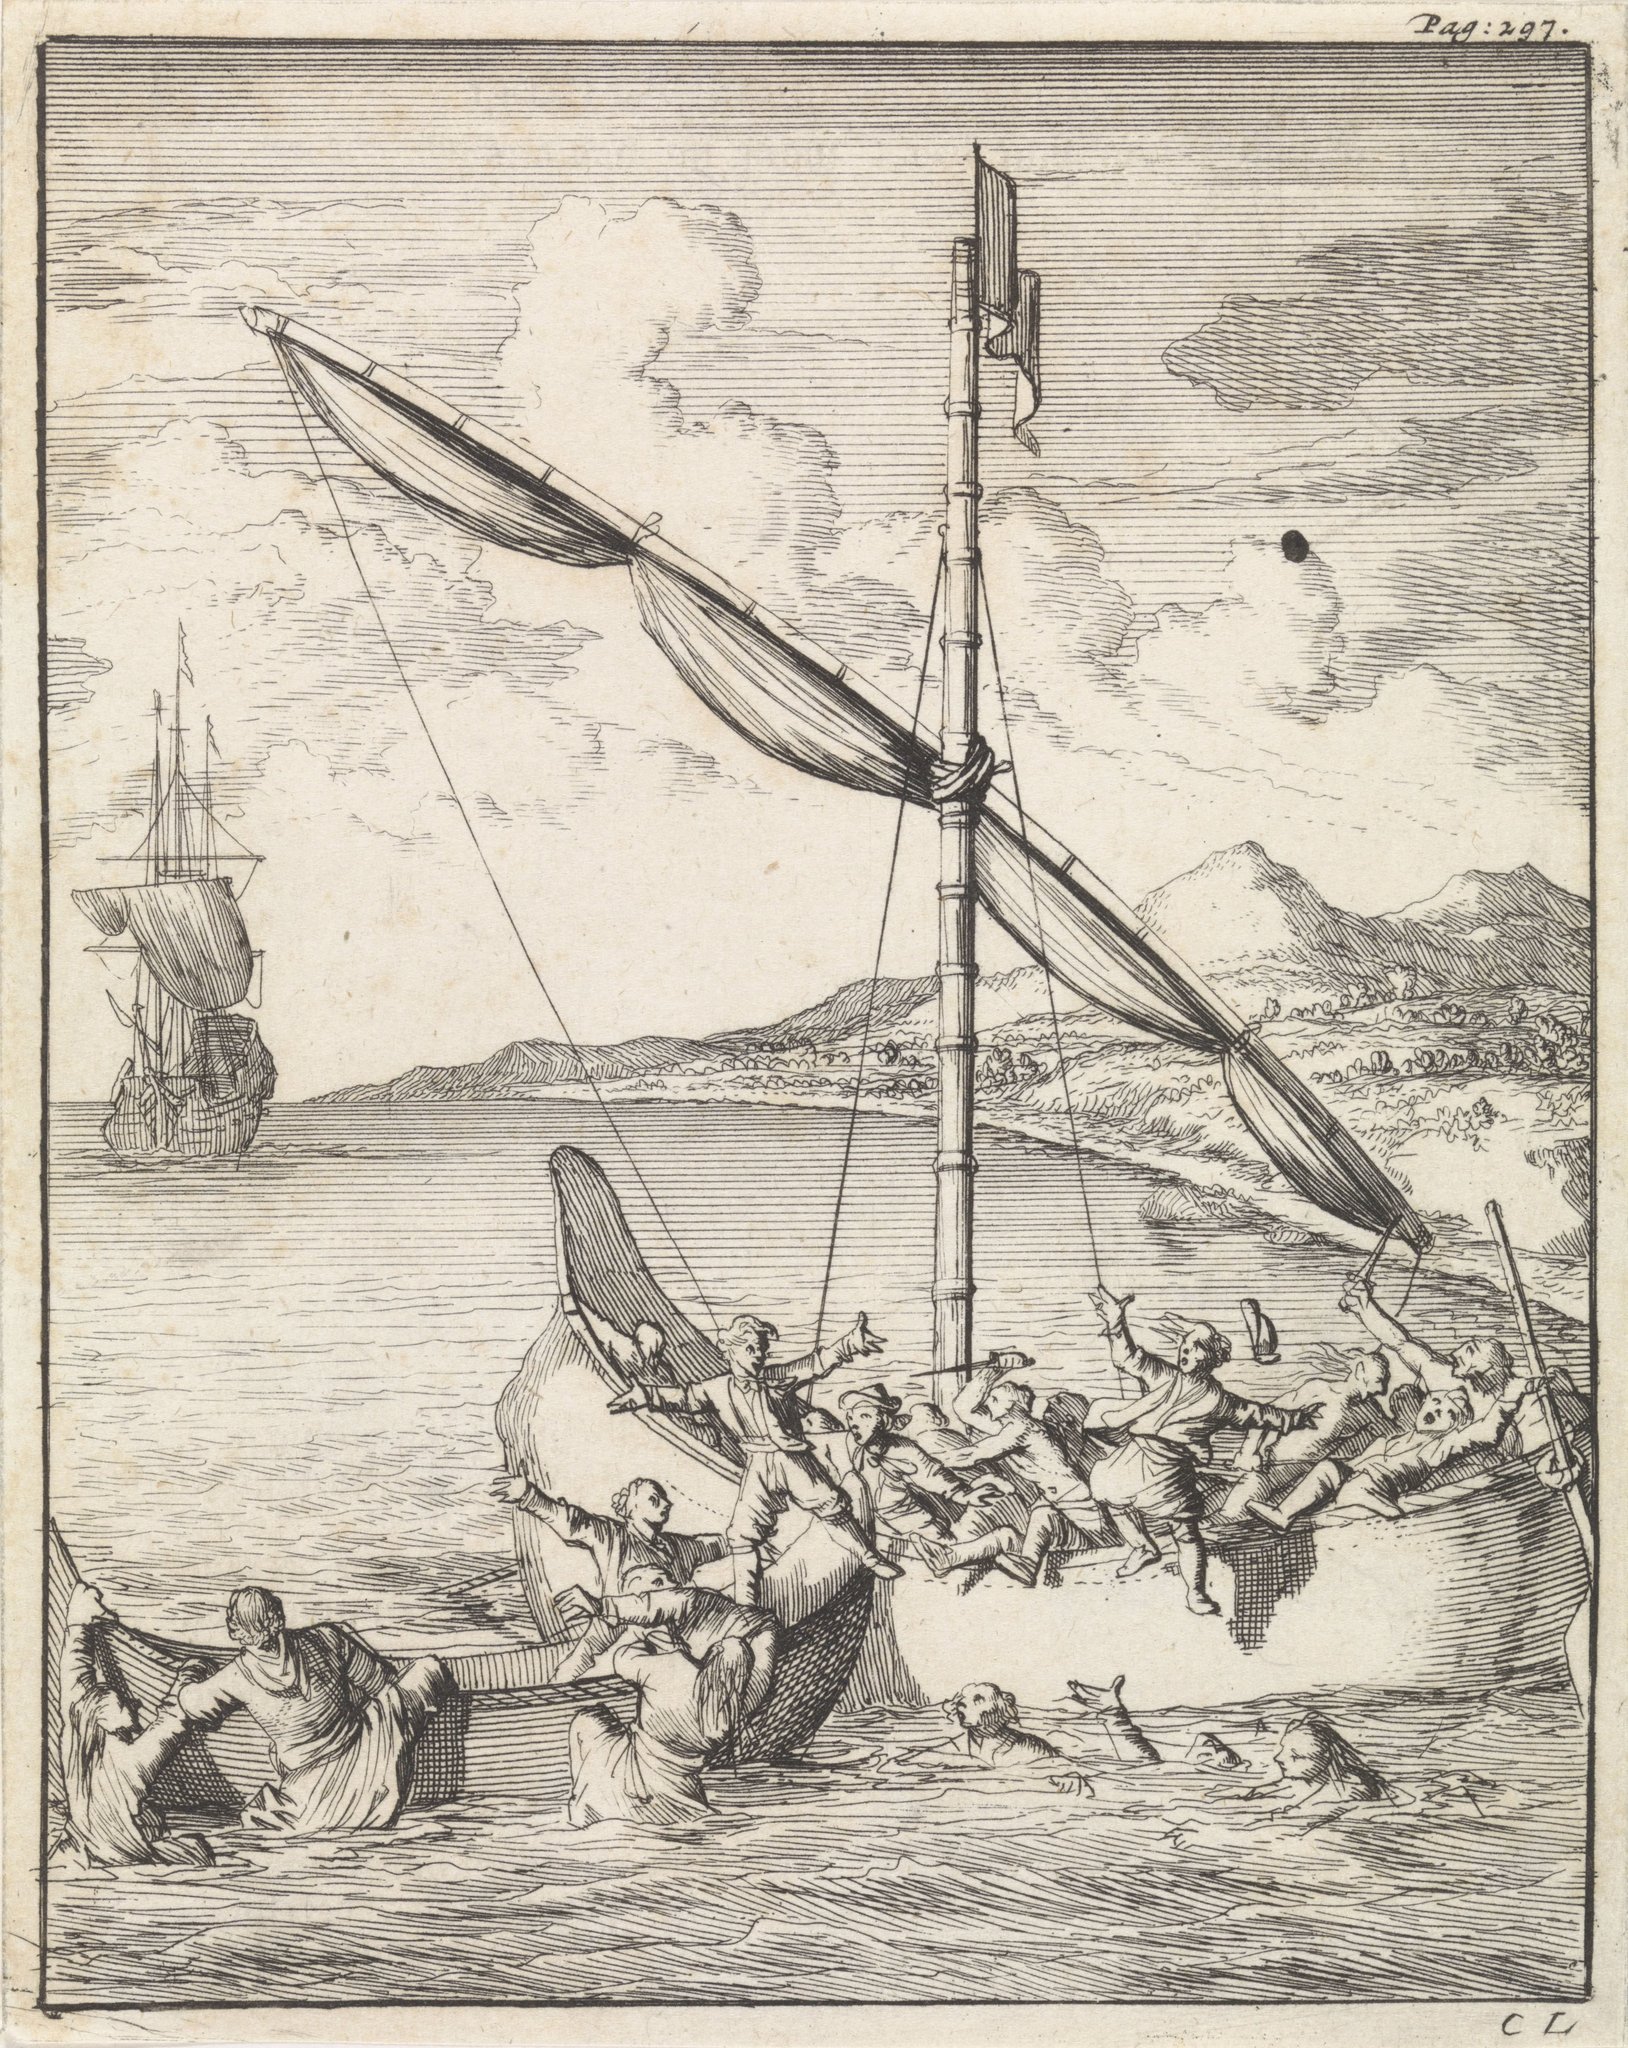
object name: book illustration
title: Gevecht op een Maleisische prauw in de baai van Siam (Thailand)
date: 1698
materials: paper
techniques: etching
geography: amsterdam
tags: gulf, bay, sailing-ship, sailing-boat, battle, thailand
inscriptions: collector's mark: Lugt 2228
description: Illustratie uit: Dampier, William. Nieuwe reystogt rondom de werreld, 3 delen (1698-1704). Den Haag: Abraham de Hondt, 1698, dl. I, p. 297.